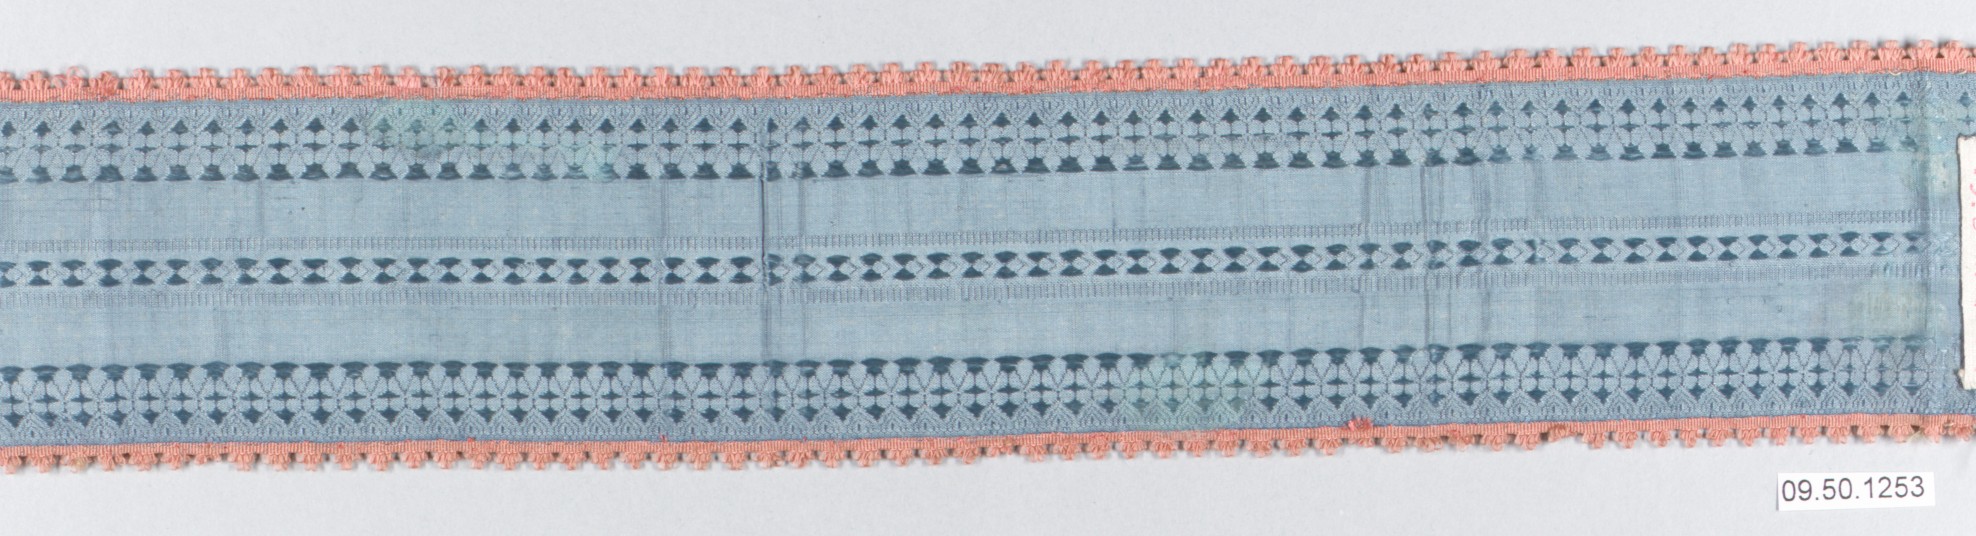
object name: ribbon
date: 1701-1800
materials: silk